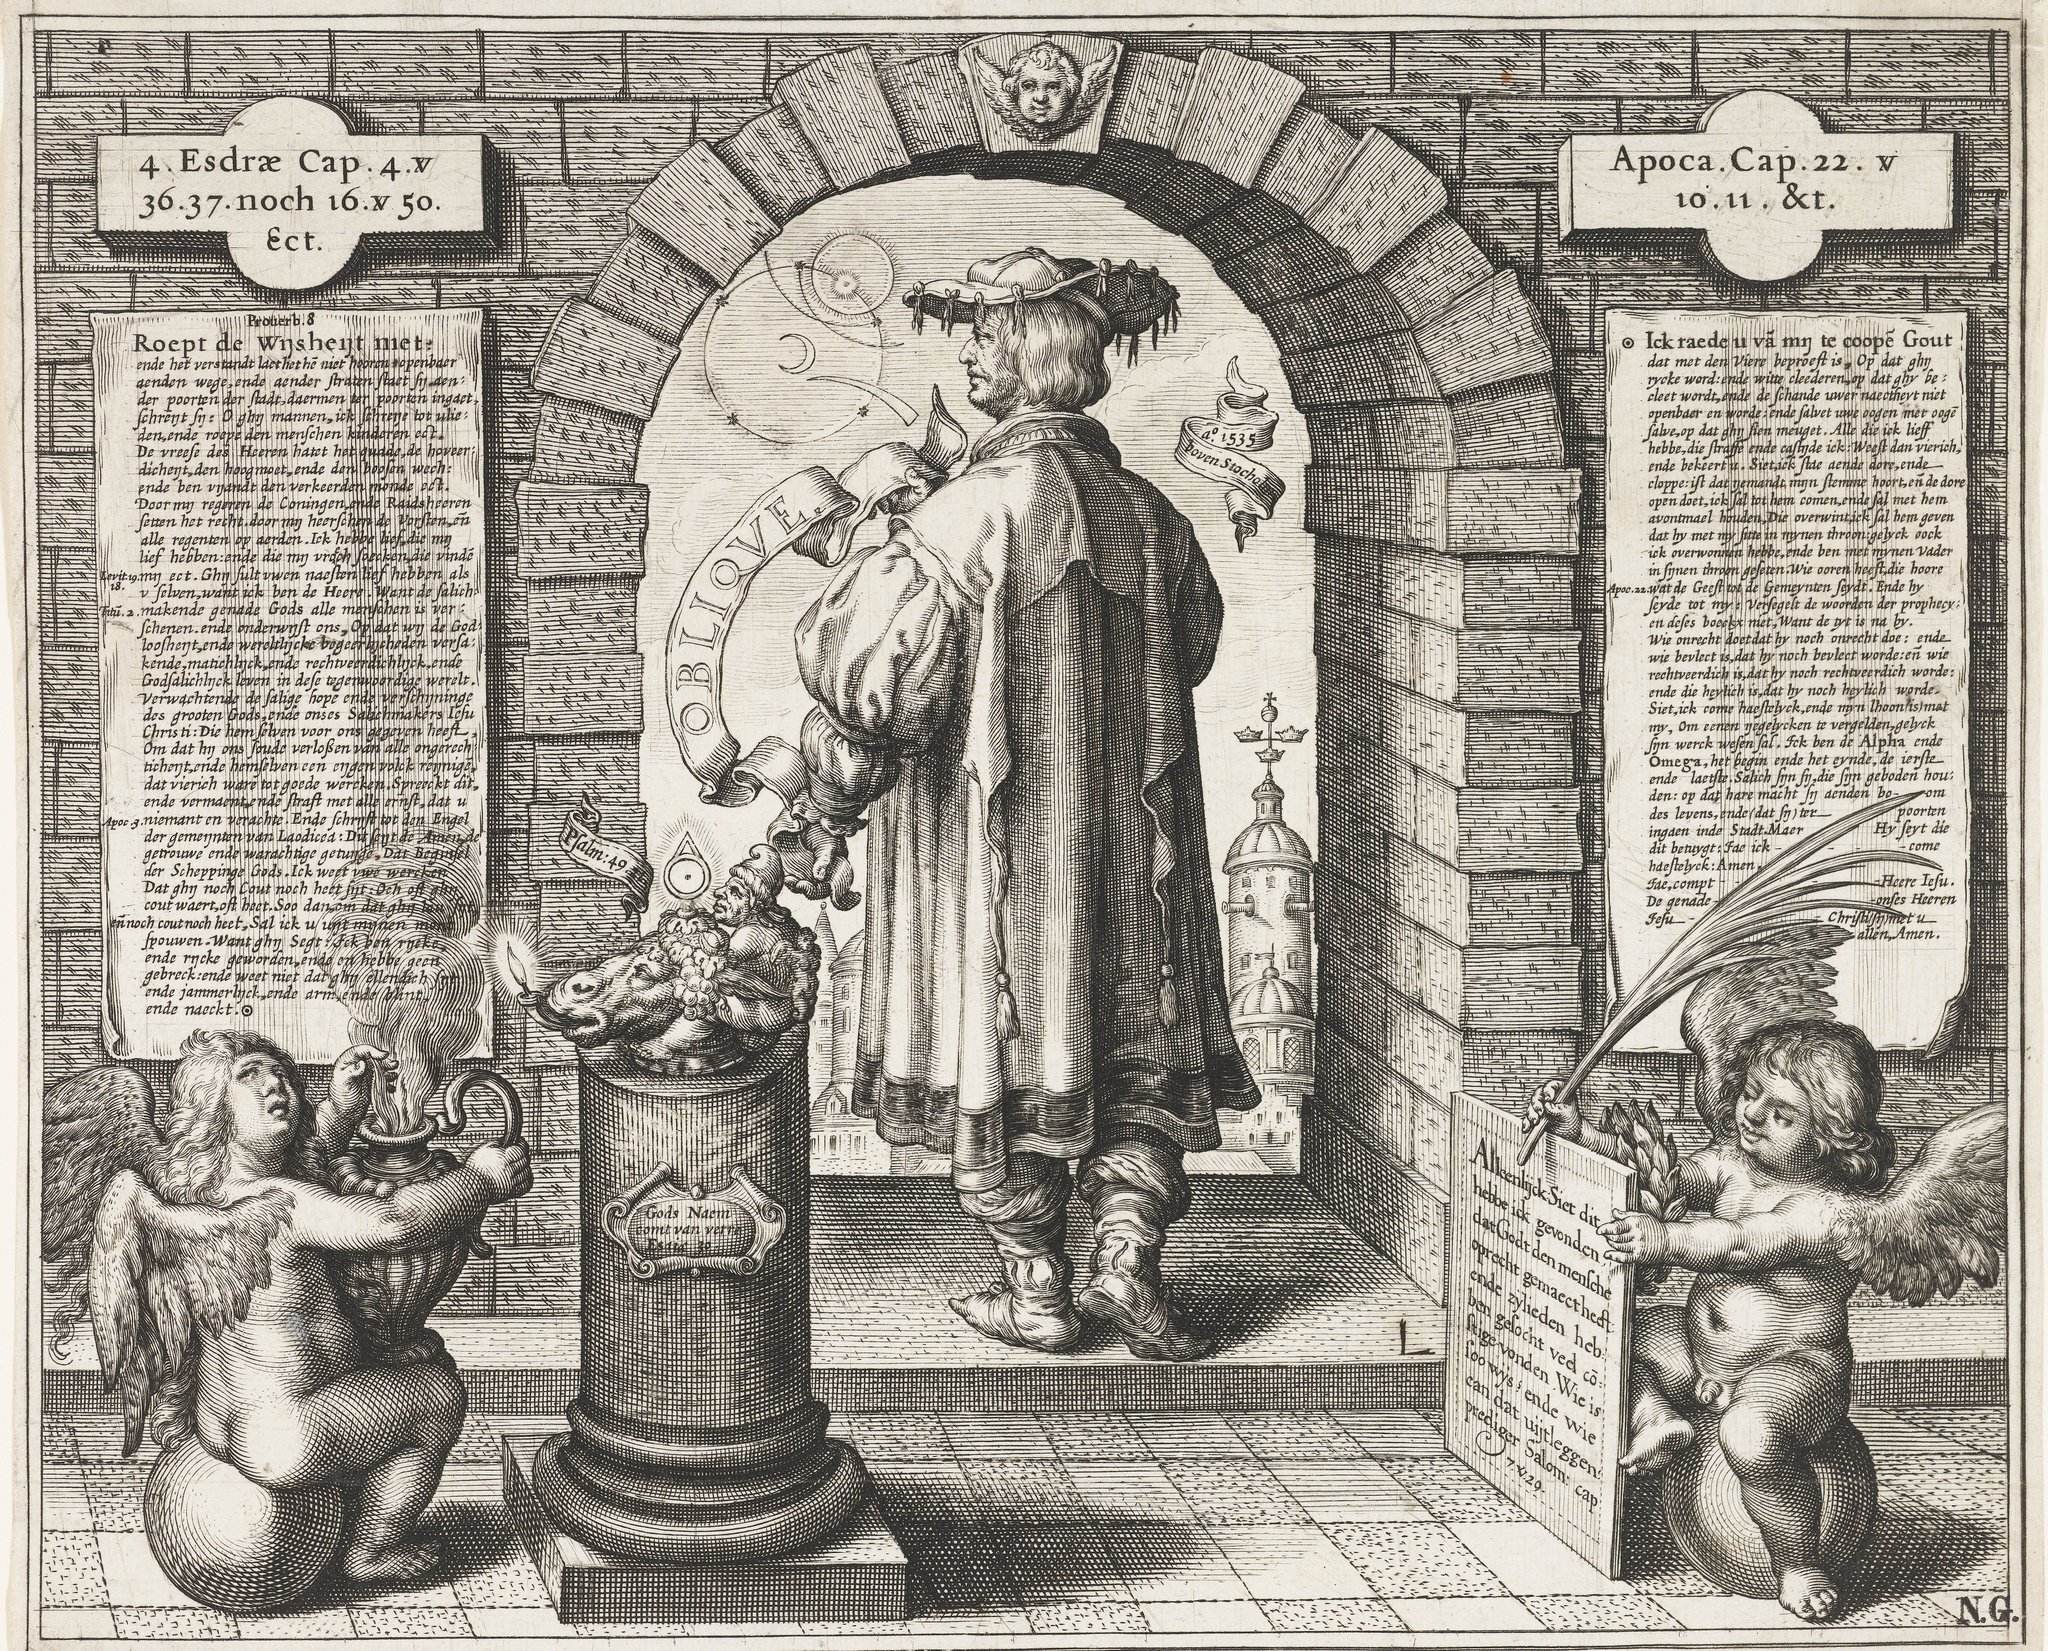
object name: print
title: Allegorische uitbeelding van een zonsverduistering te Stockholm in 1535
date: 1596-1600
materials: paper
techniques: engraving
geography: haarlem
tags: solar eclipse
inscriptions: collector's mark: Lugt 1967, inscription: ‘poruf (?) XVI op H. Hondius’, collector's mark: Lugt 2228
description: Een man staande in een poort, op de rug gezien. Door het portaal een doorkijk naar een stad. In de lucht de zon, maan en sterren. Links een putto met een rokende pot, rechts een putto met palmtak en lauwerkrans.